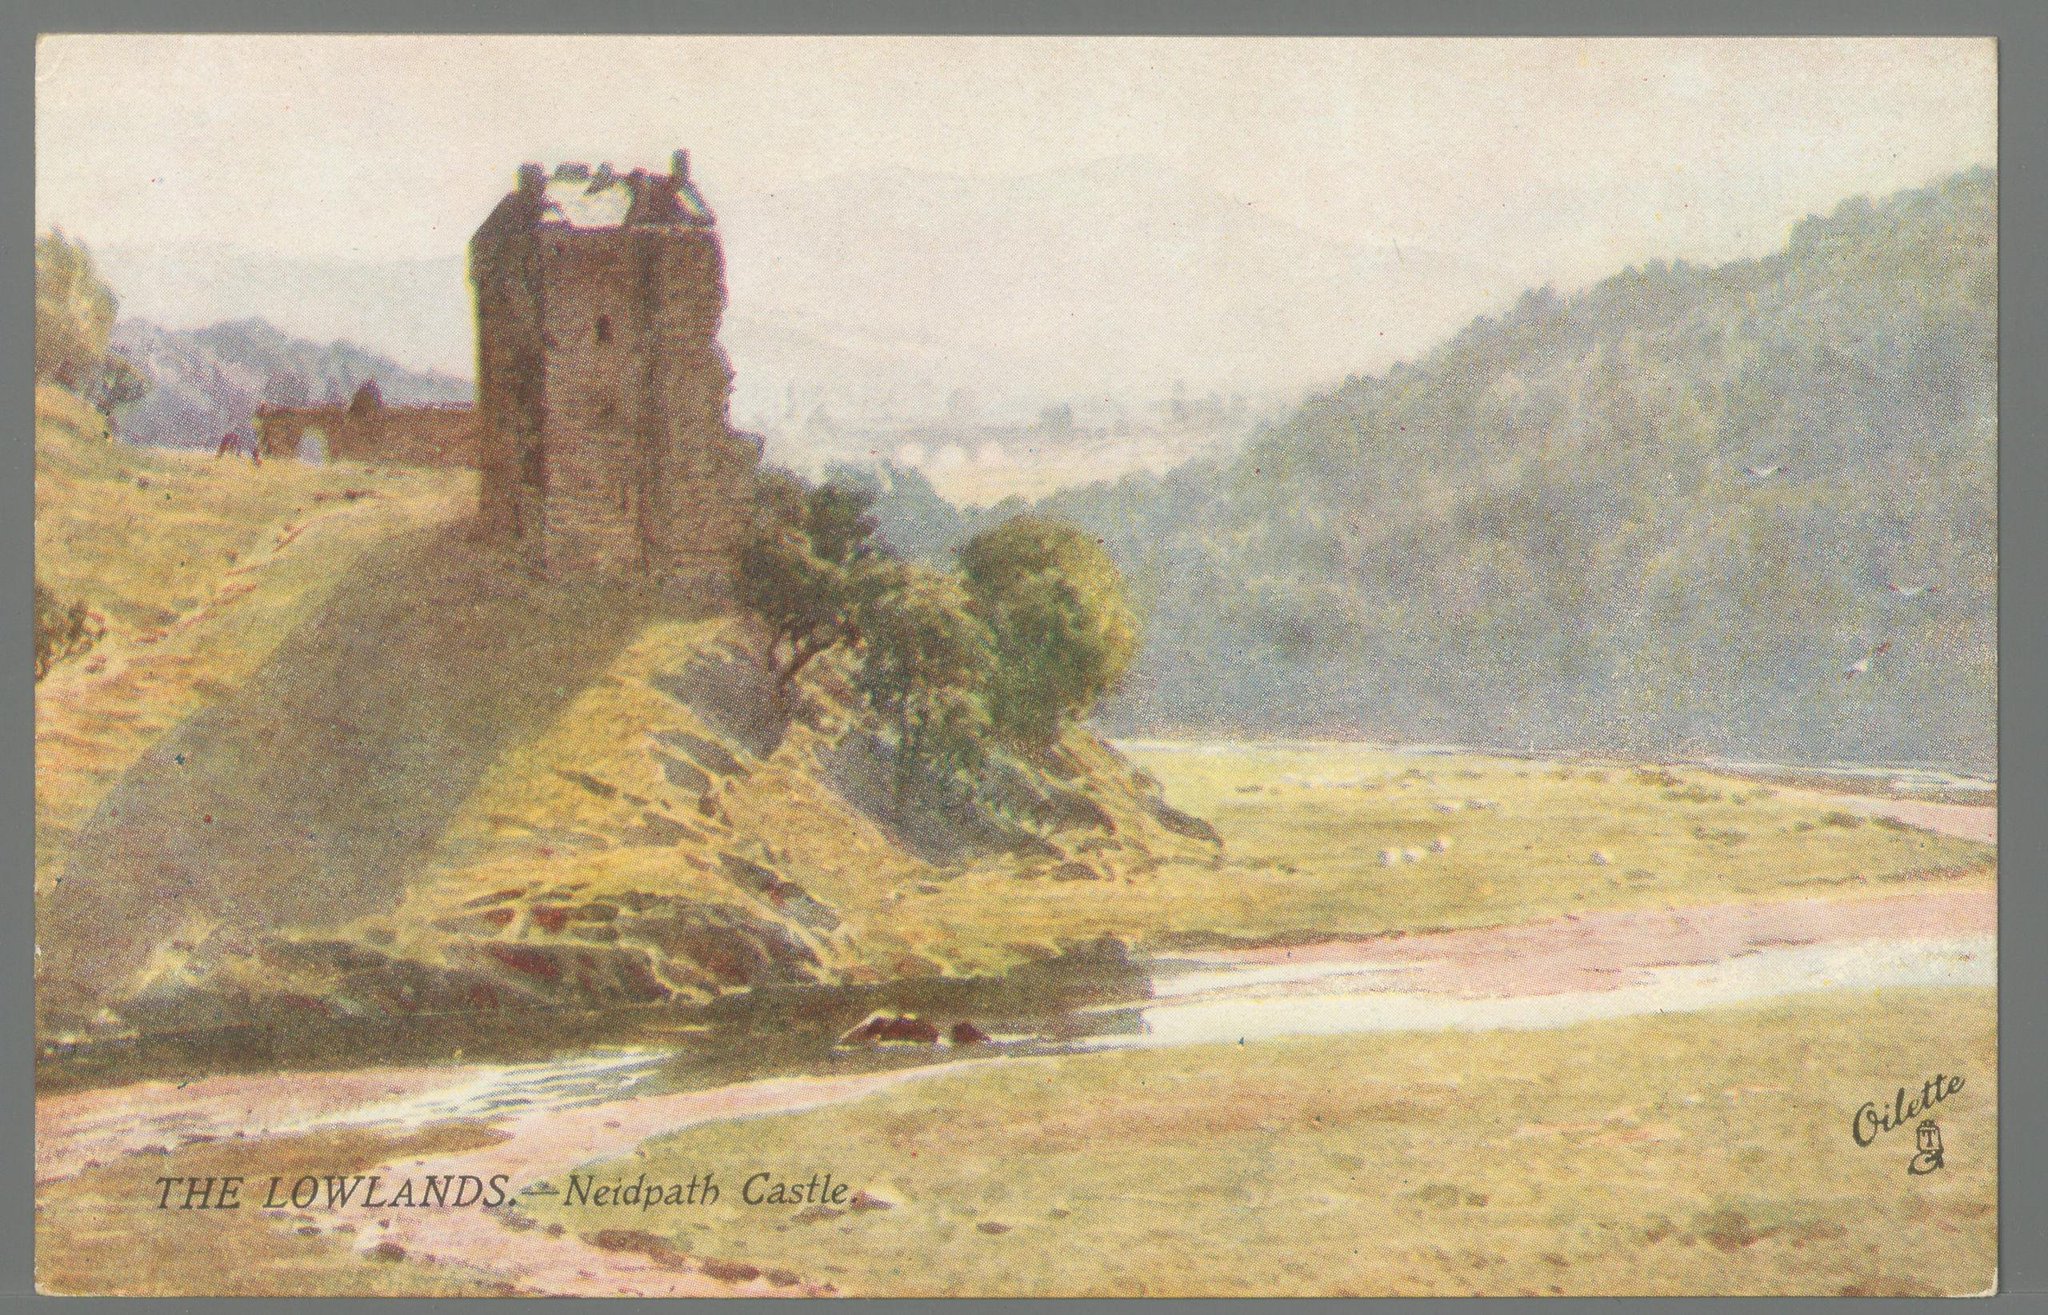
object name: ansichtkaart, prentbriefkaart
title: "Bonnie Scotland."-The Lowlands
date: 1906-1912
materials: cardboard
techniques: color autotype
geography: england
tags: castle